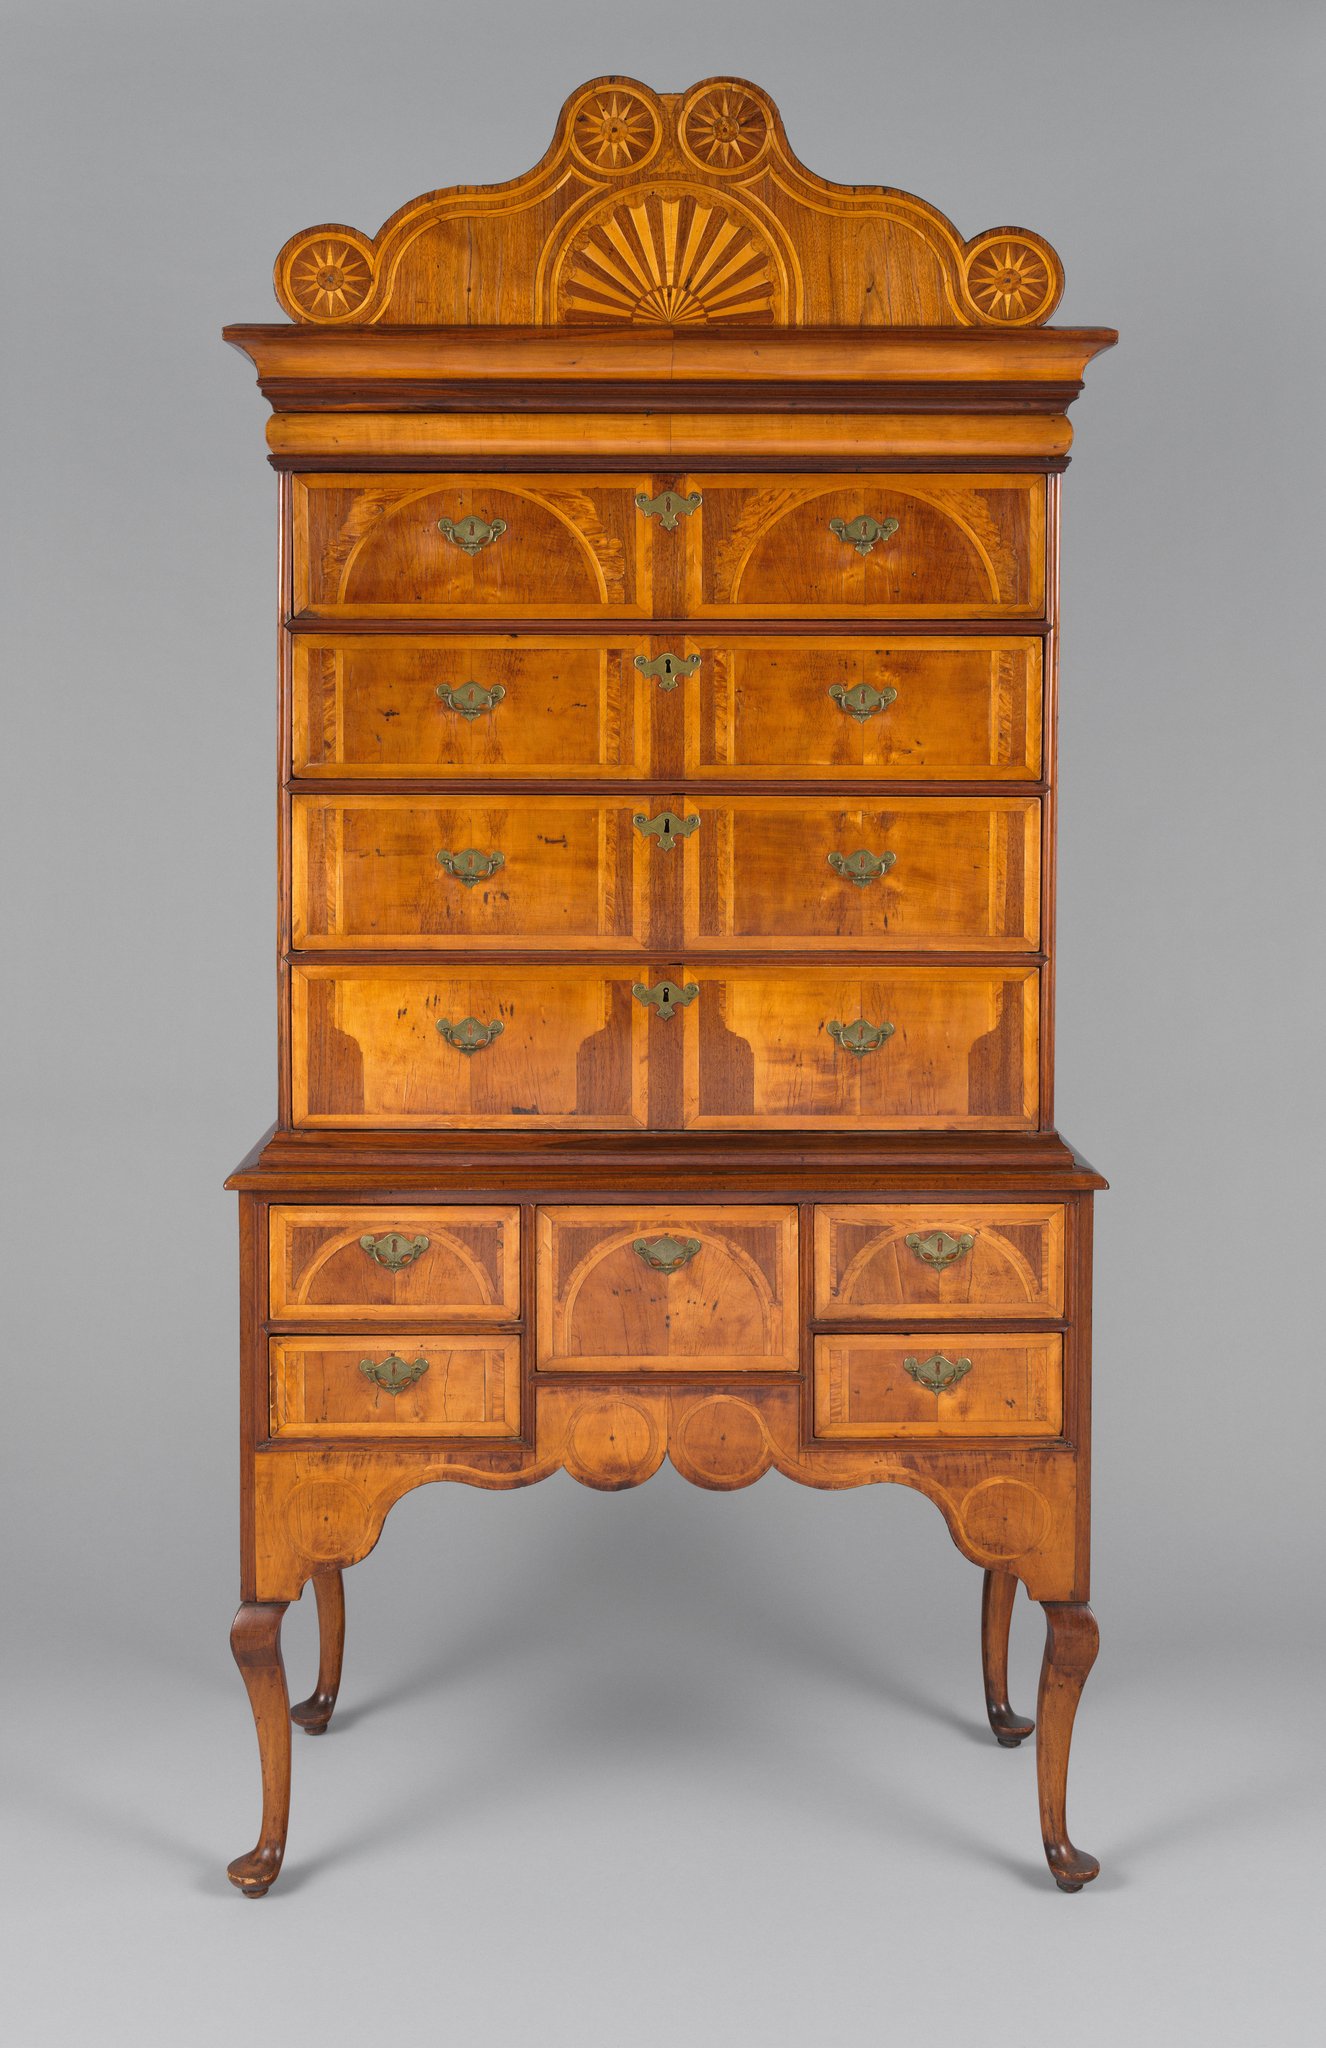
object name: high chest of drawer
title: High Chest of Drawers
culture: american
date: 1730-1750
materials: brass, wood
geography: united states